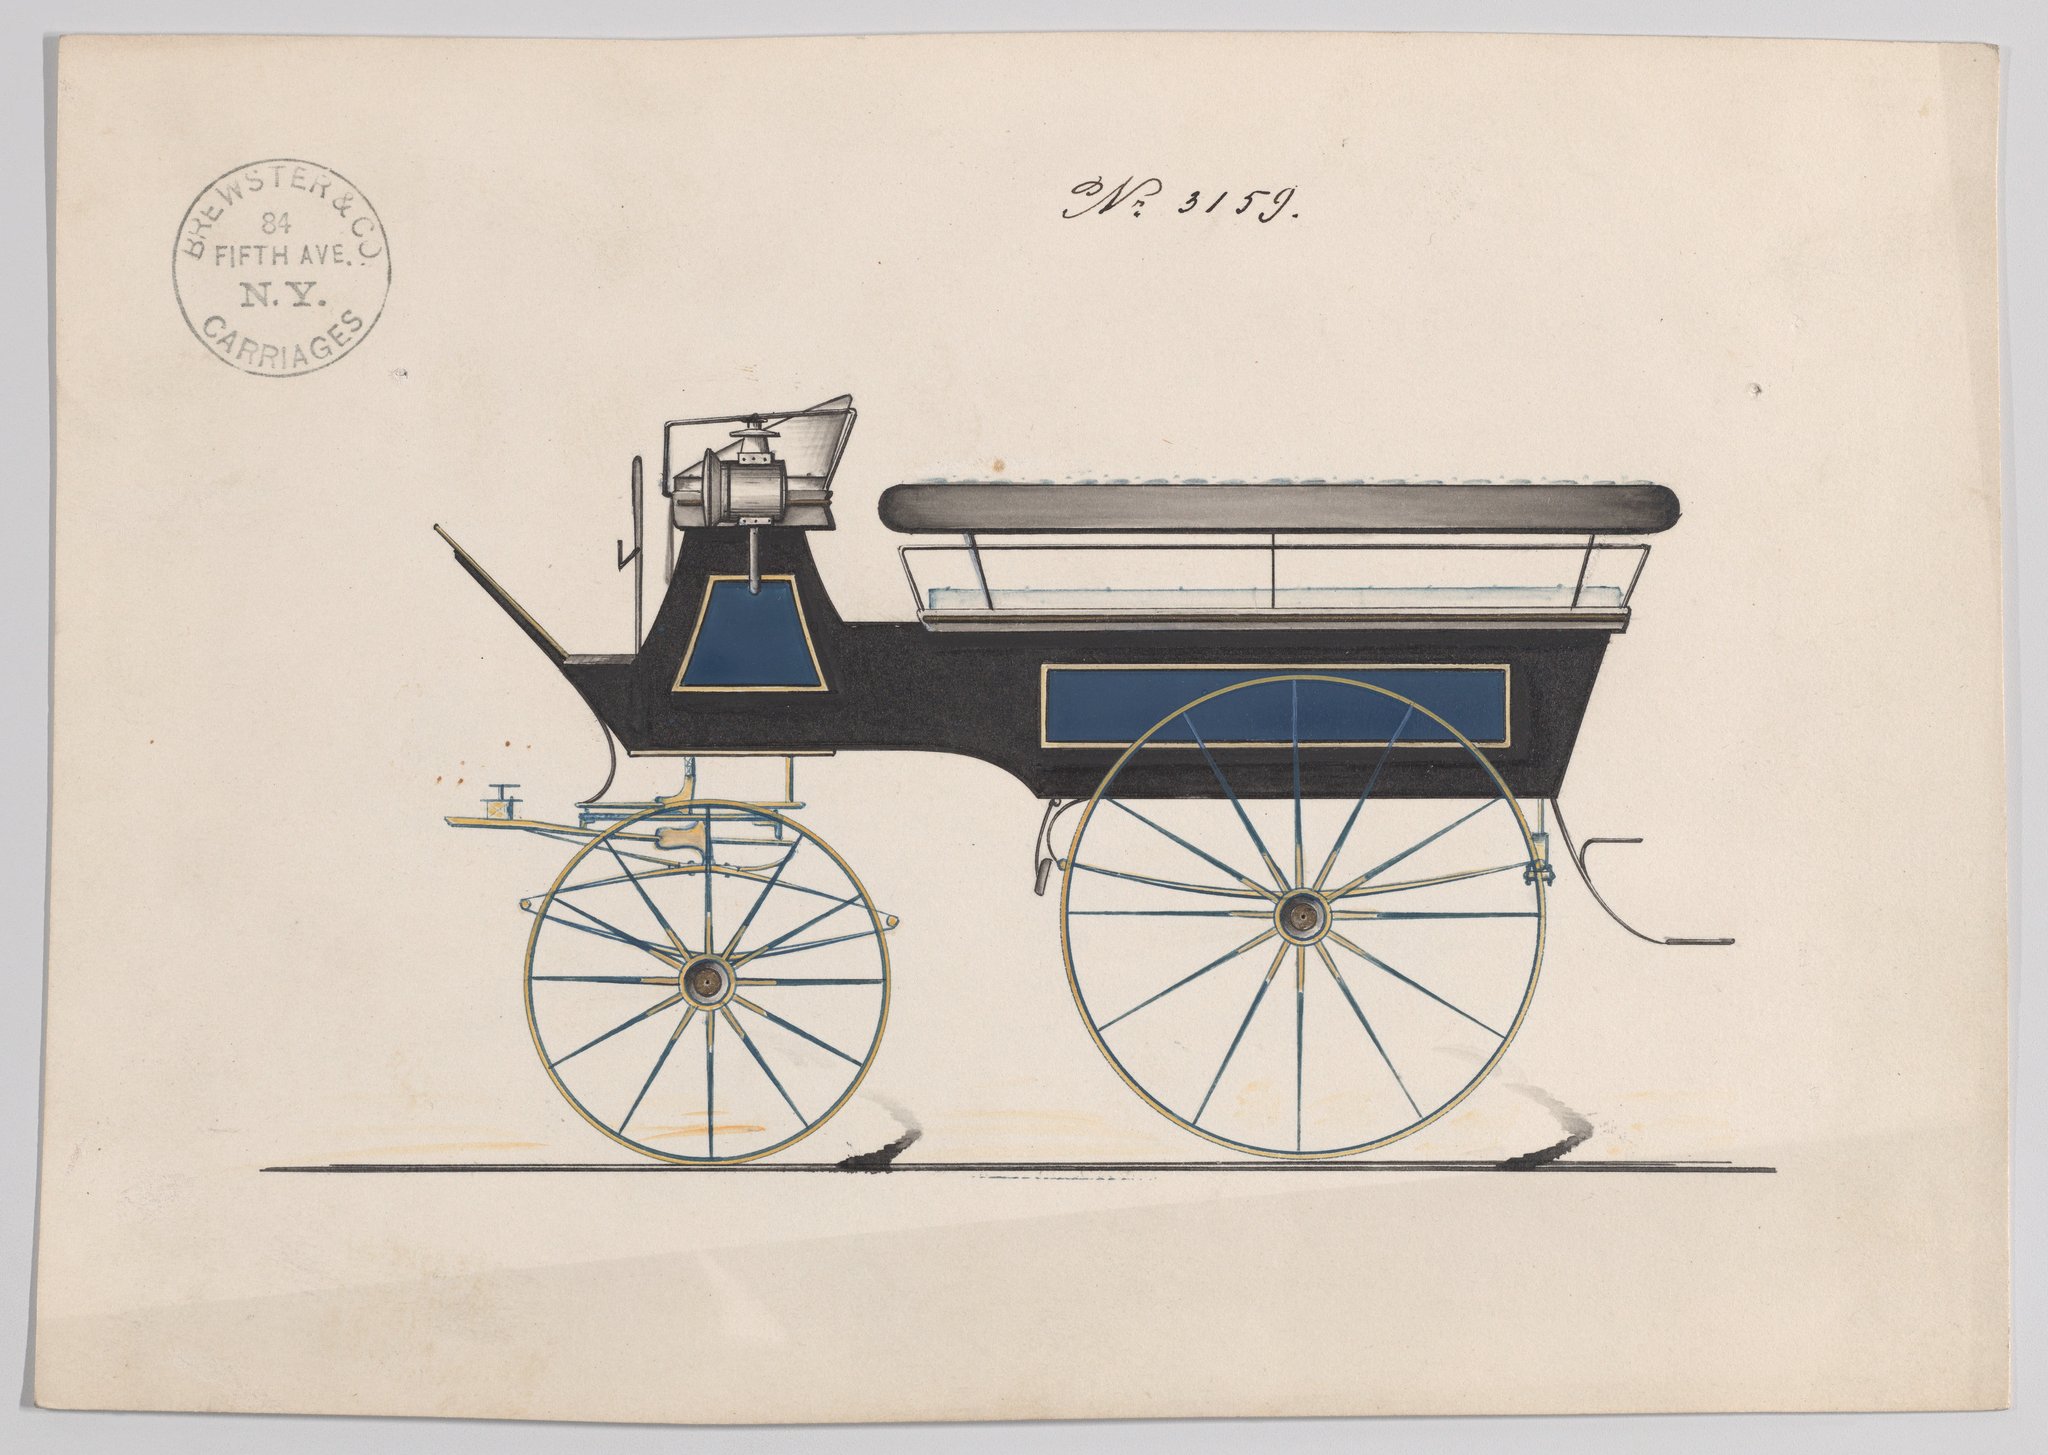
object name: drawing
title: Design for a Wagonette, no. 3159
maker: brewster & co.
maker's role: manufacturer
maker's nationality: american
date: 1875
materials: gouache, gum arabic, ink, watercolor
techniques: pen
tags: carriages